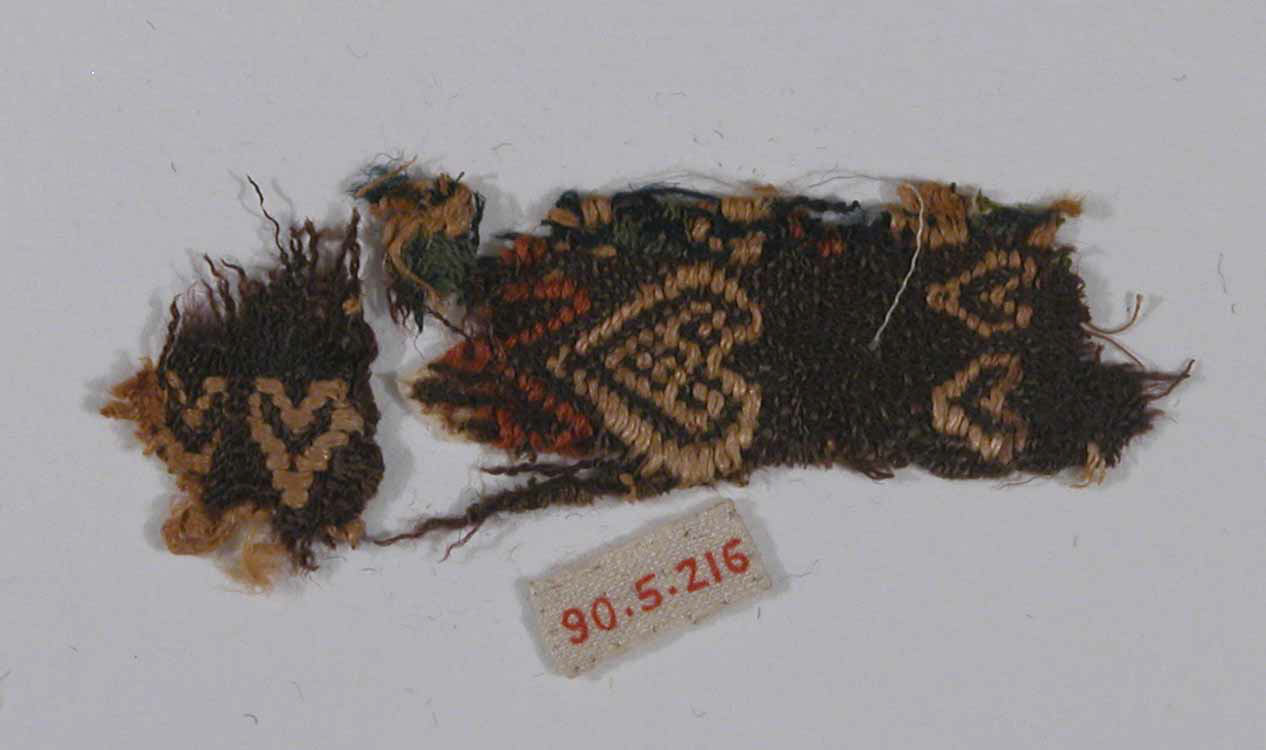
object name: textile fragment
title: Fragment of a Band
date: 501-700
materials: linen, wool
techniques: weave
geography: egypt